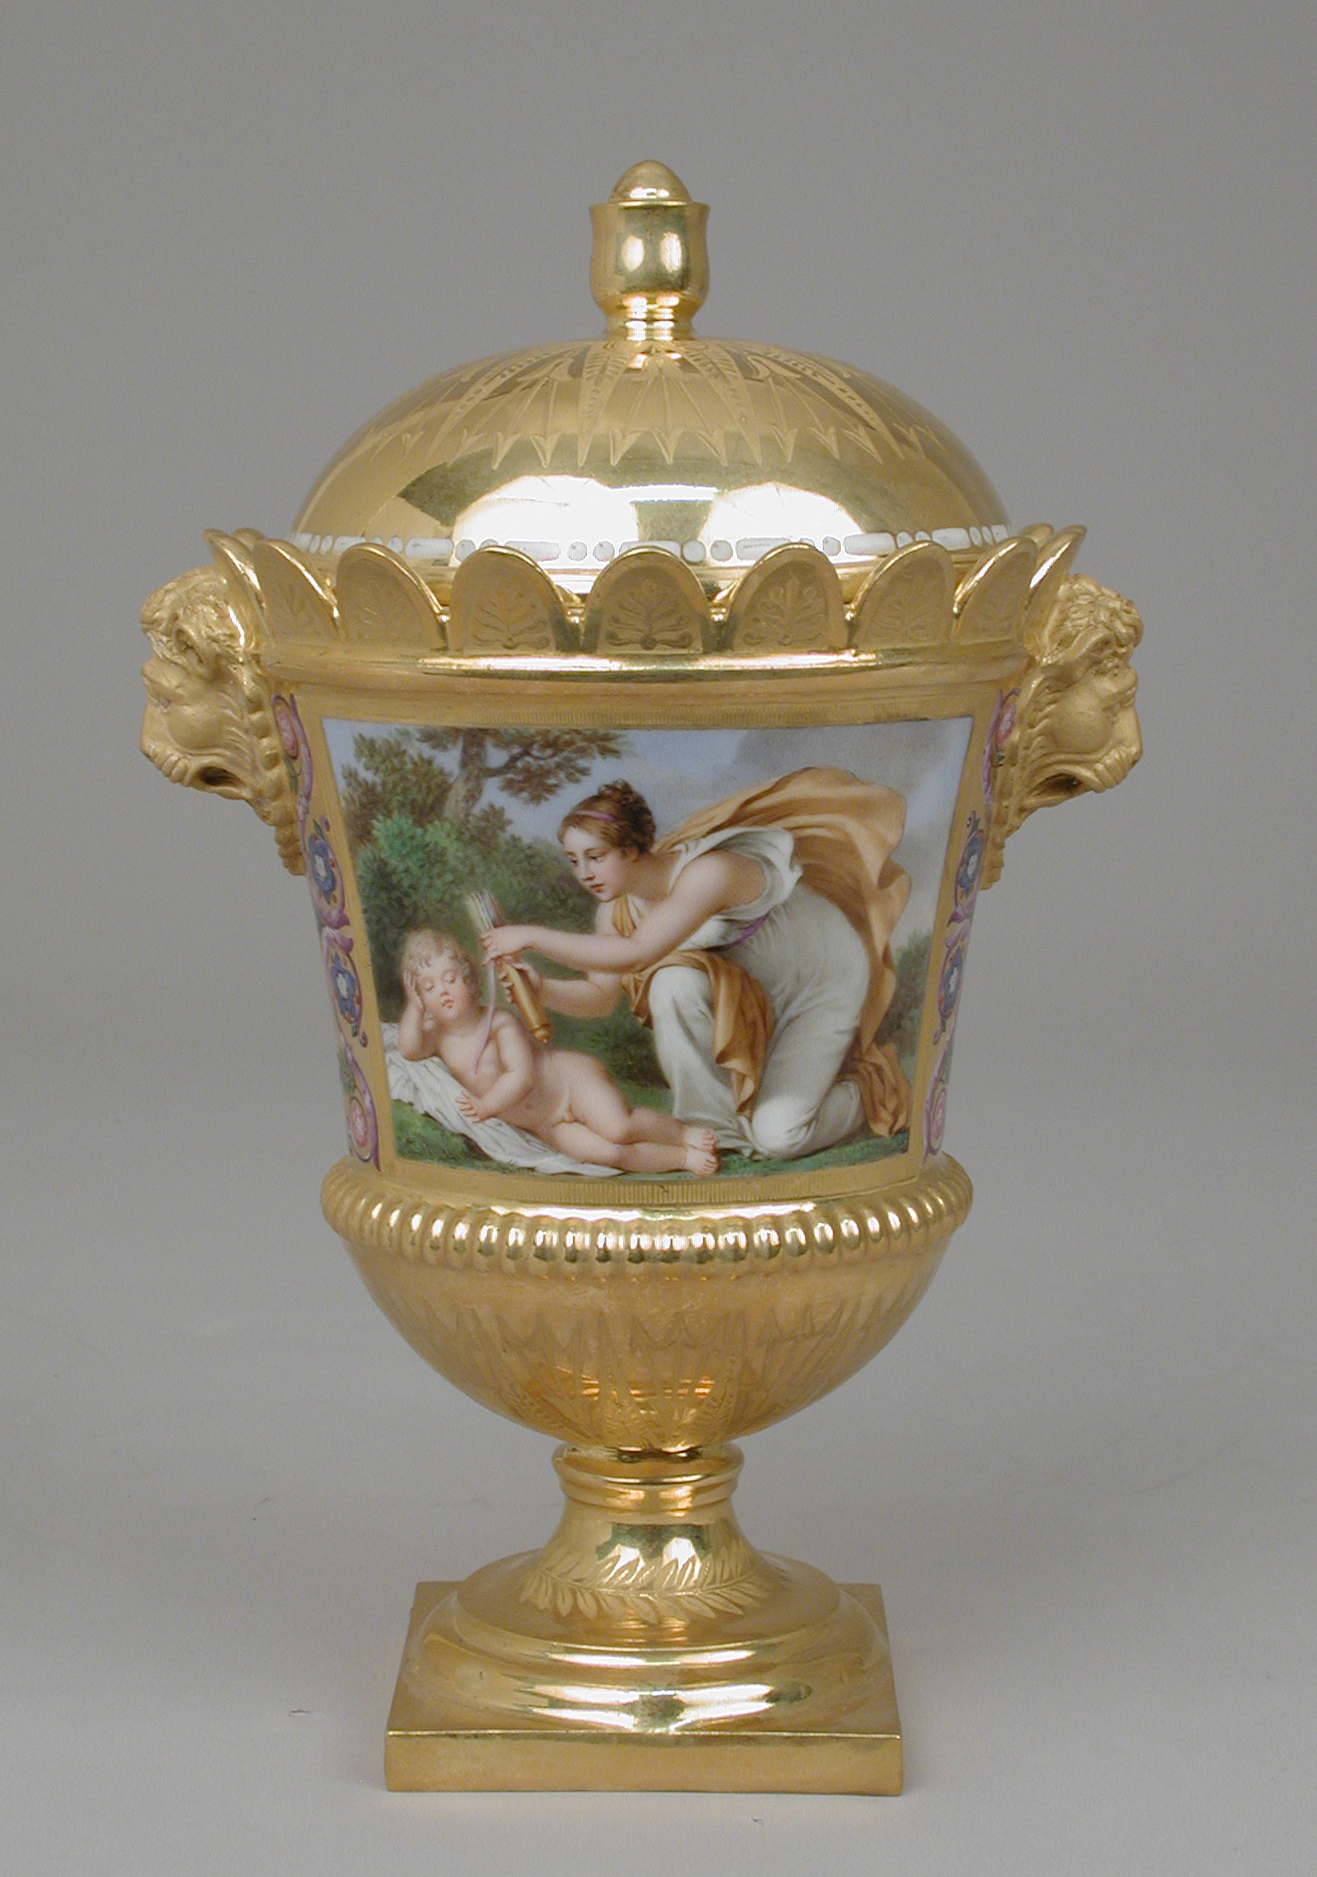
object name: sugar bowl with cover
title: Sugar bowl with cover, part of Breakfast Service (déjeuner)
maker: sèvres manufactory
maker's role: manufactory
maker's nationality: french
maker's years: 1740-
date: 1813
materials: hard paste porcelain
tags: infants,women,trees